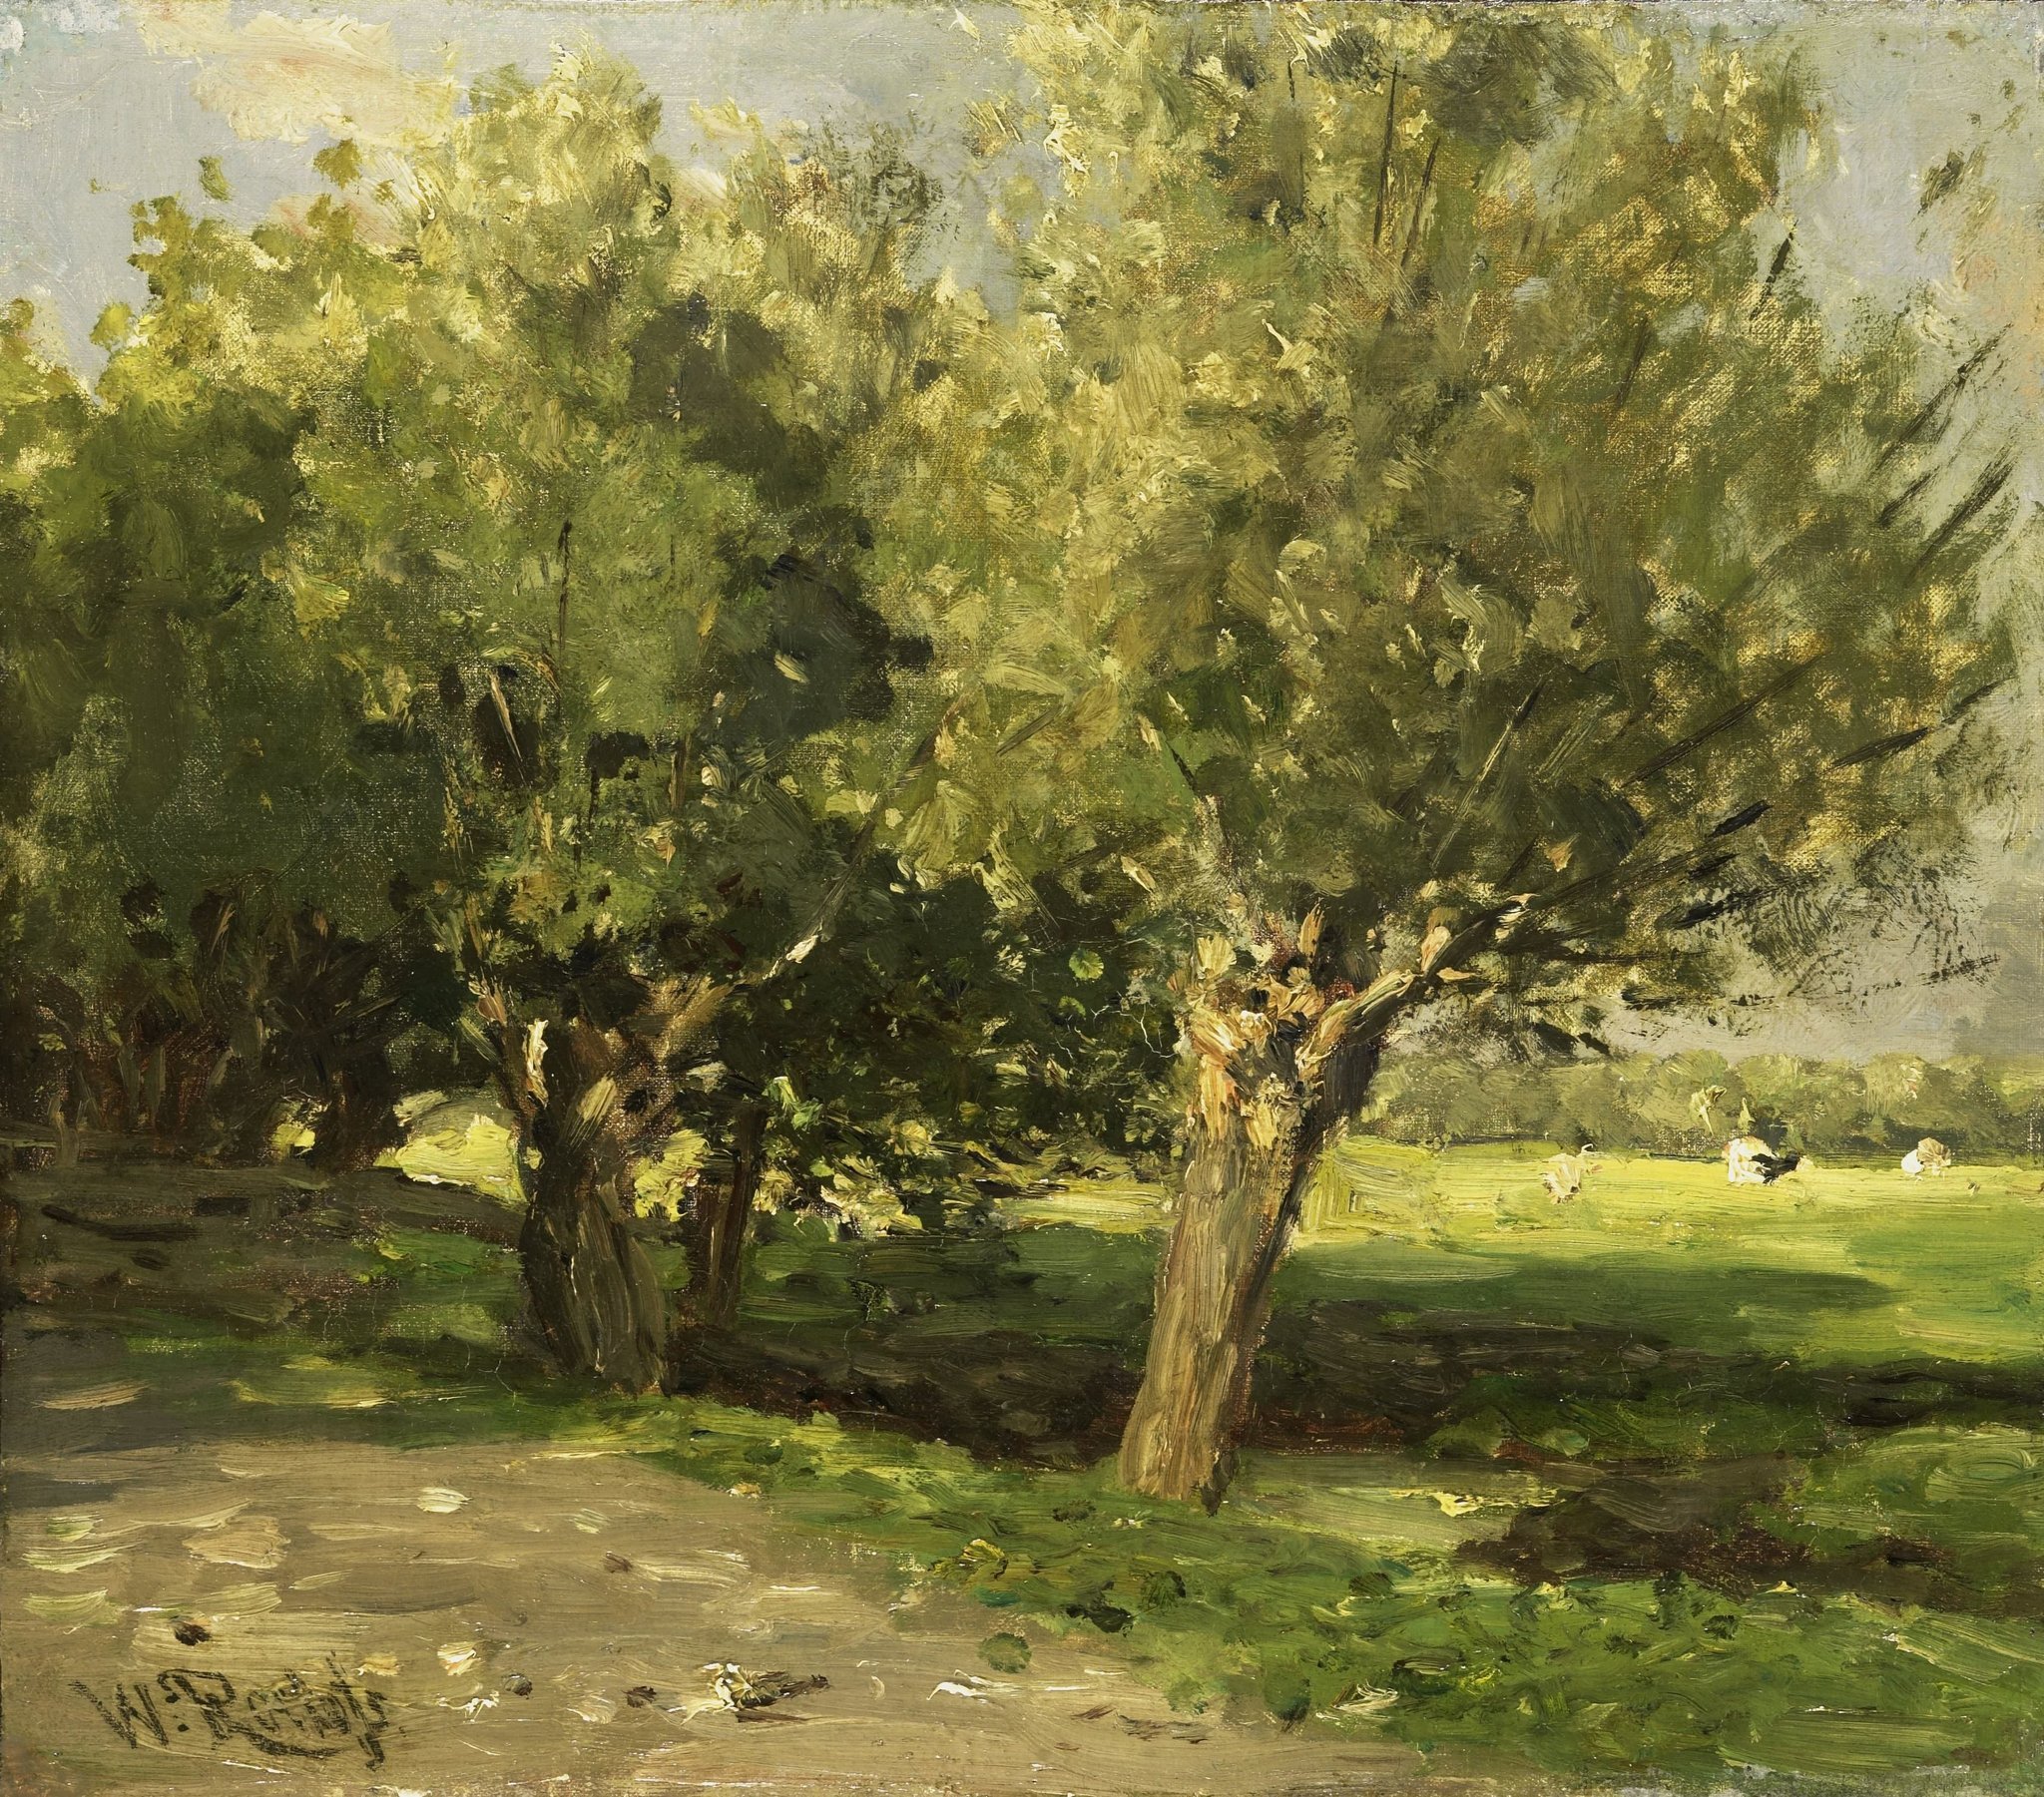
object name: painting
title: Wilgebomen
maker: willem roelofs (i)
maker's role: draughtsman, painter, print maker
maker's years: 1822-1897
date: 1875-1885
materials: canvas, oil, panel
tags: groups of trees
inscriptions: signature: ‘W. Roelofs’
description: Studie van wilgebomen bij een sloot aan de rand van een weiland. In de verte vee, op de voorgrond een weg.